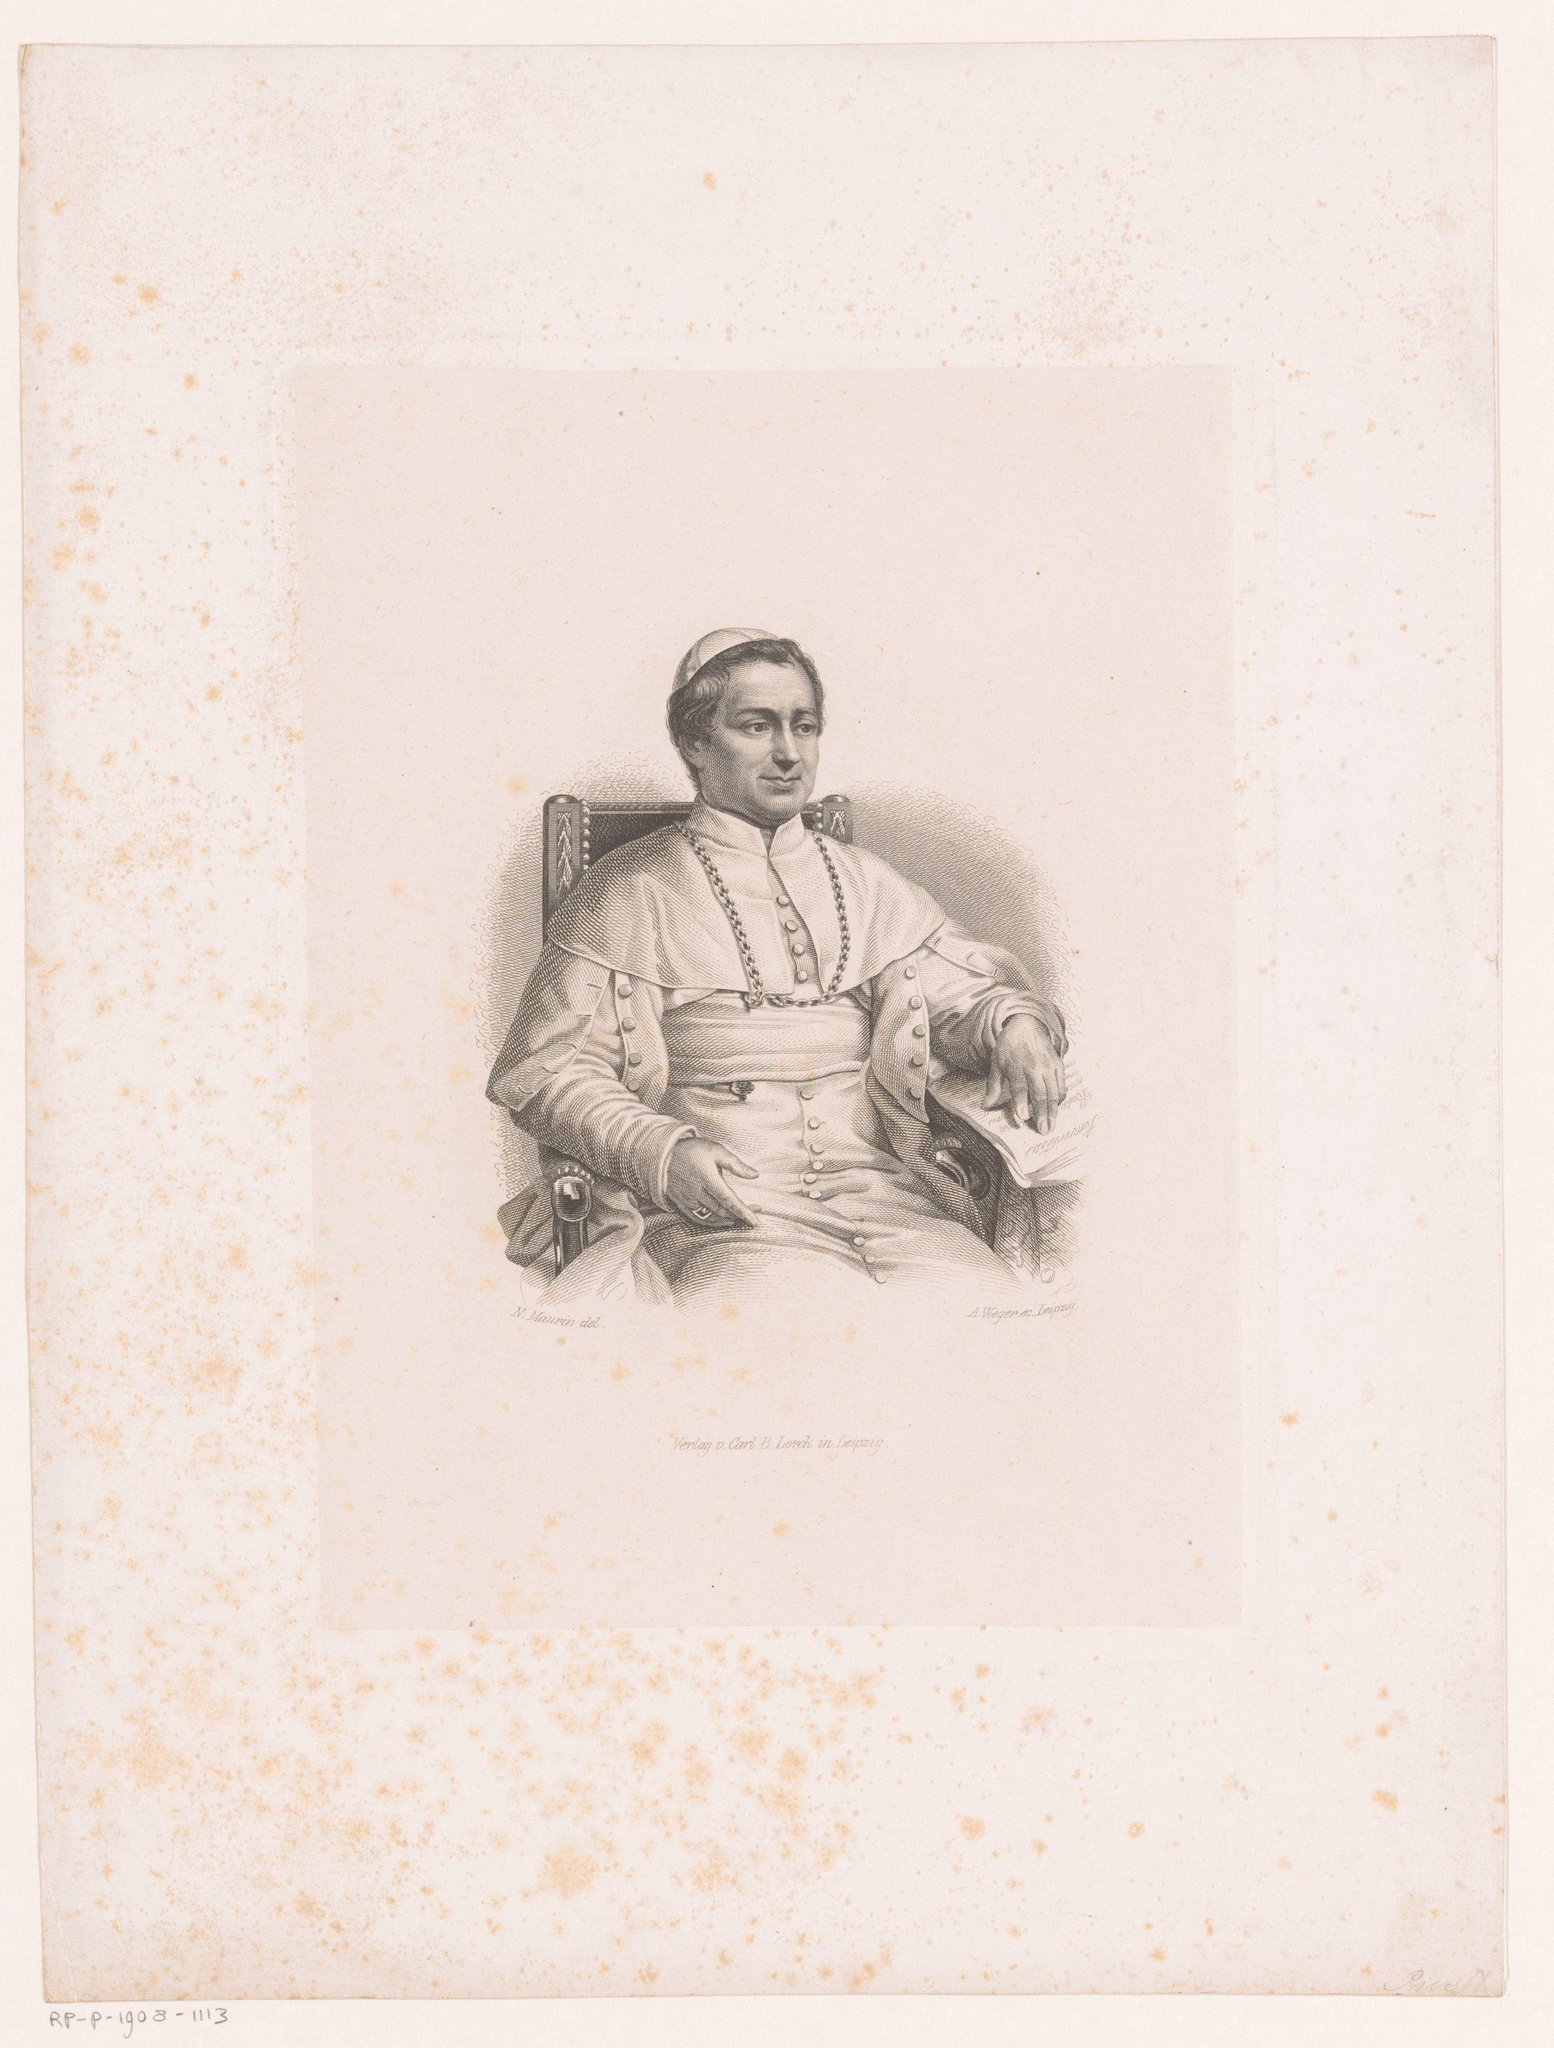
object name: print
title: Portret van paus Pius IX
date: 1849-1892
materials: paper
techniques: engraving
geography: leipzig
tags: historical persons, pope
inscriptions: collector's mark: Lugt 2228